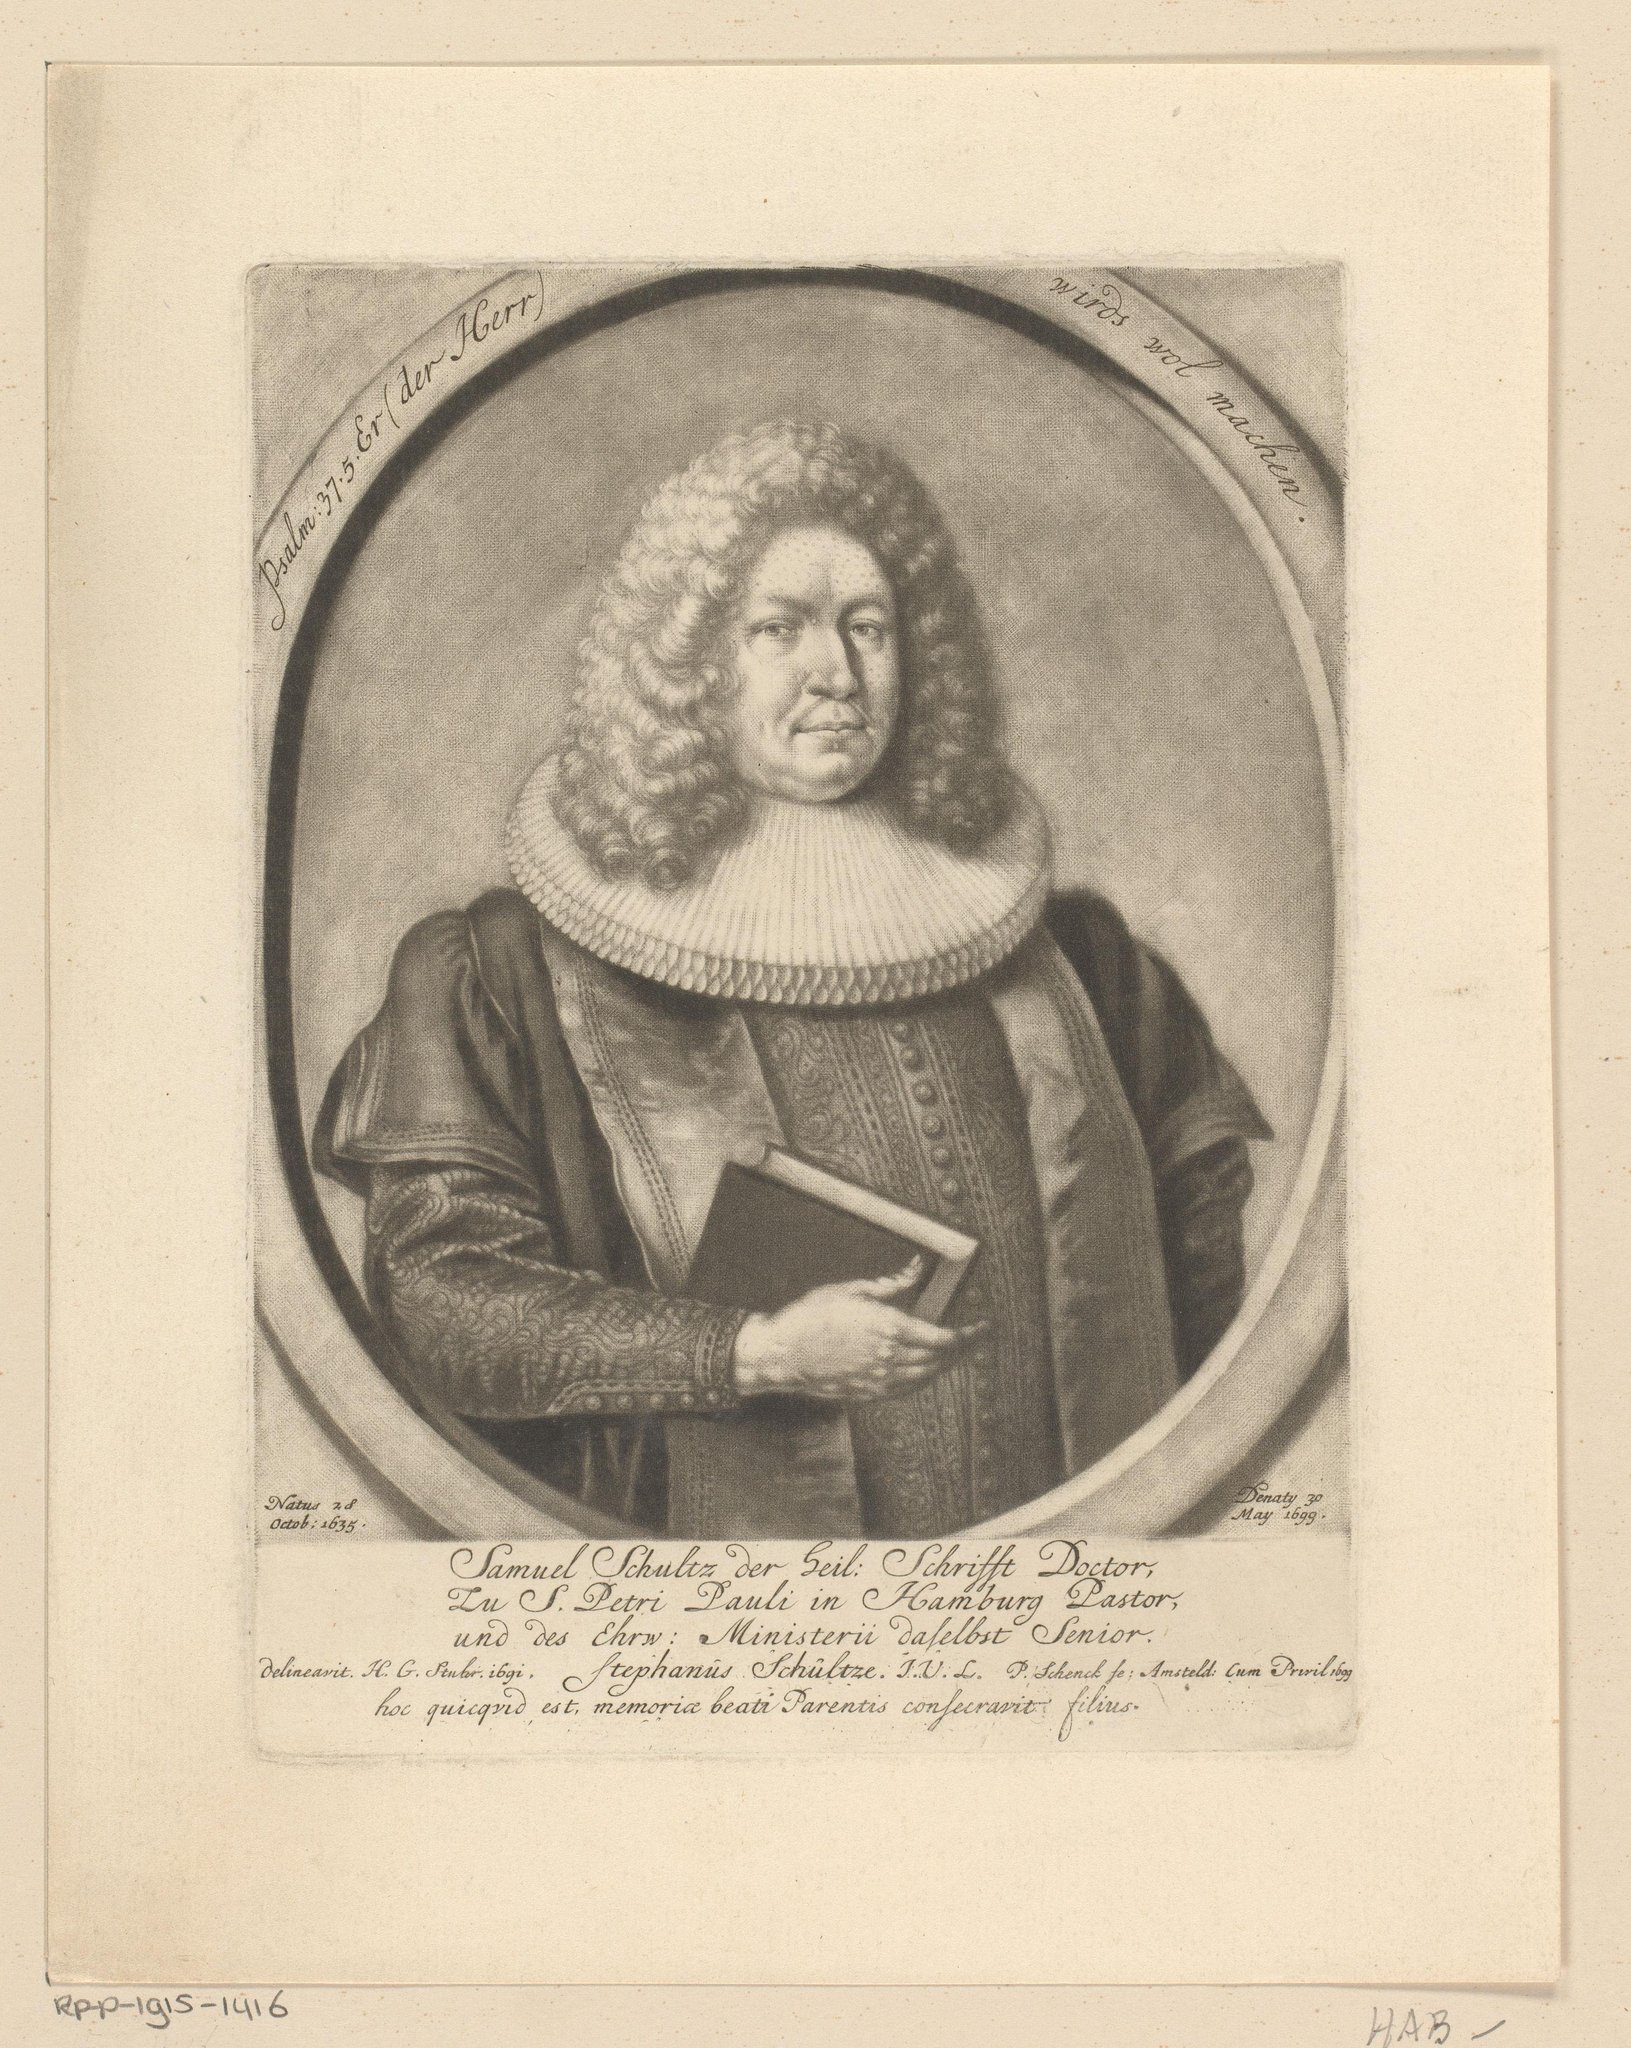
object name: print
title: Portret van Samuel Schultz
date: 1699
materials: paper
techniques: engraving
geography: amsterdam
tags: theologian, historical persons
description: Met drieregelig onderschrift in het Duits en tekst in het Duits boven het portret.